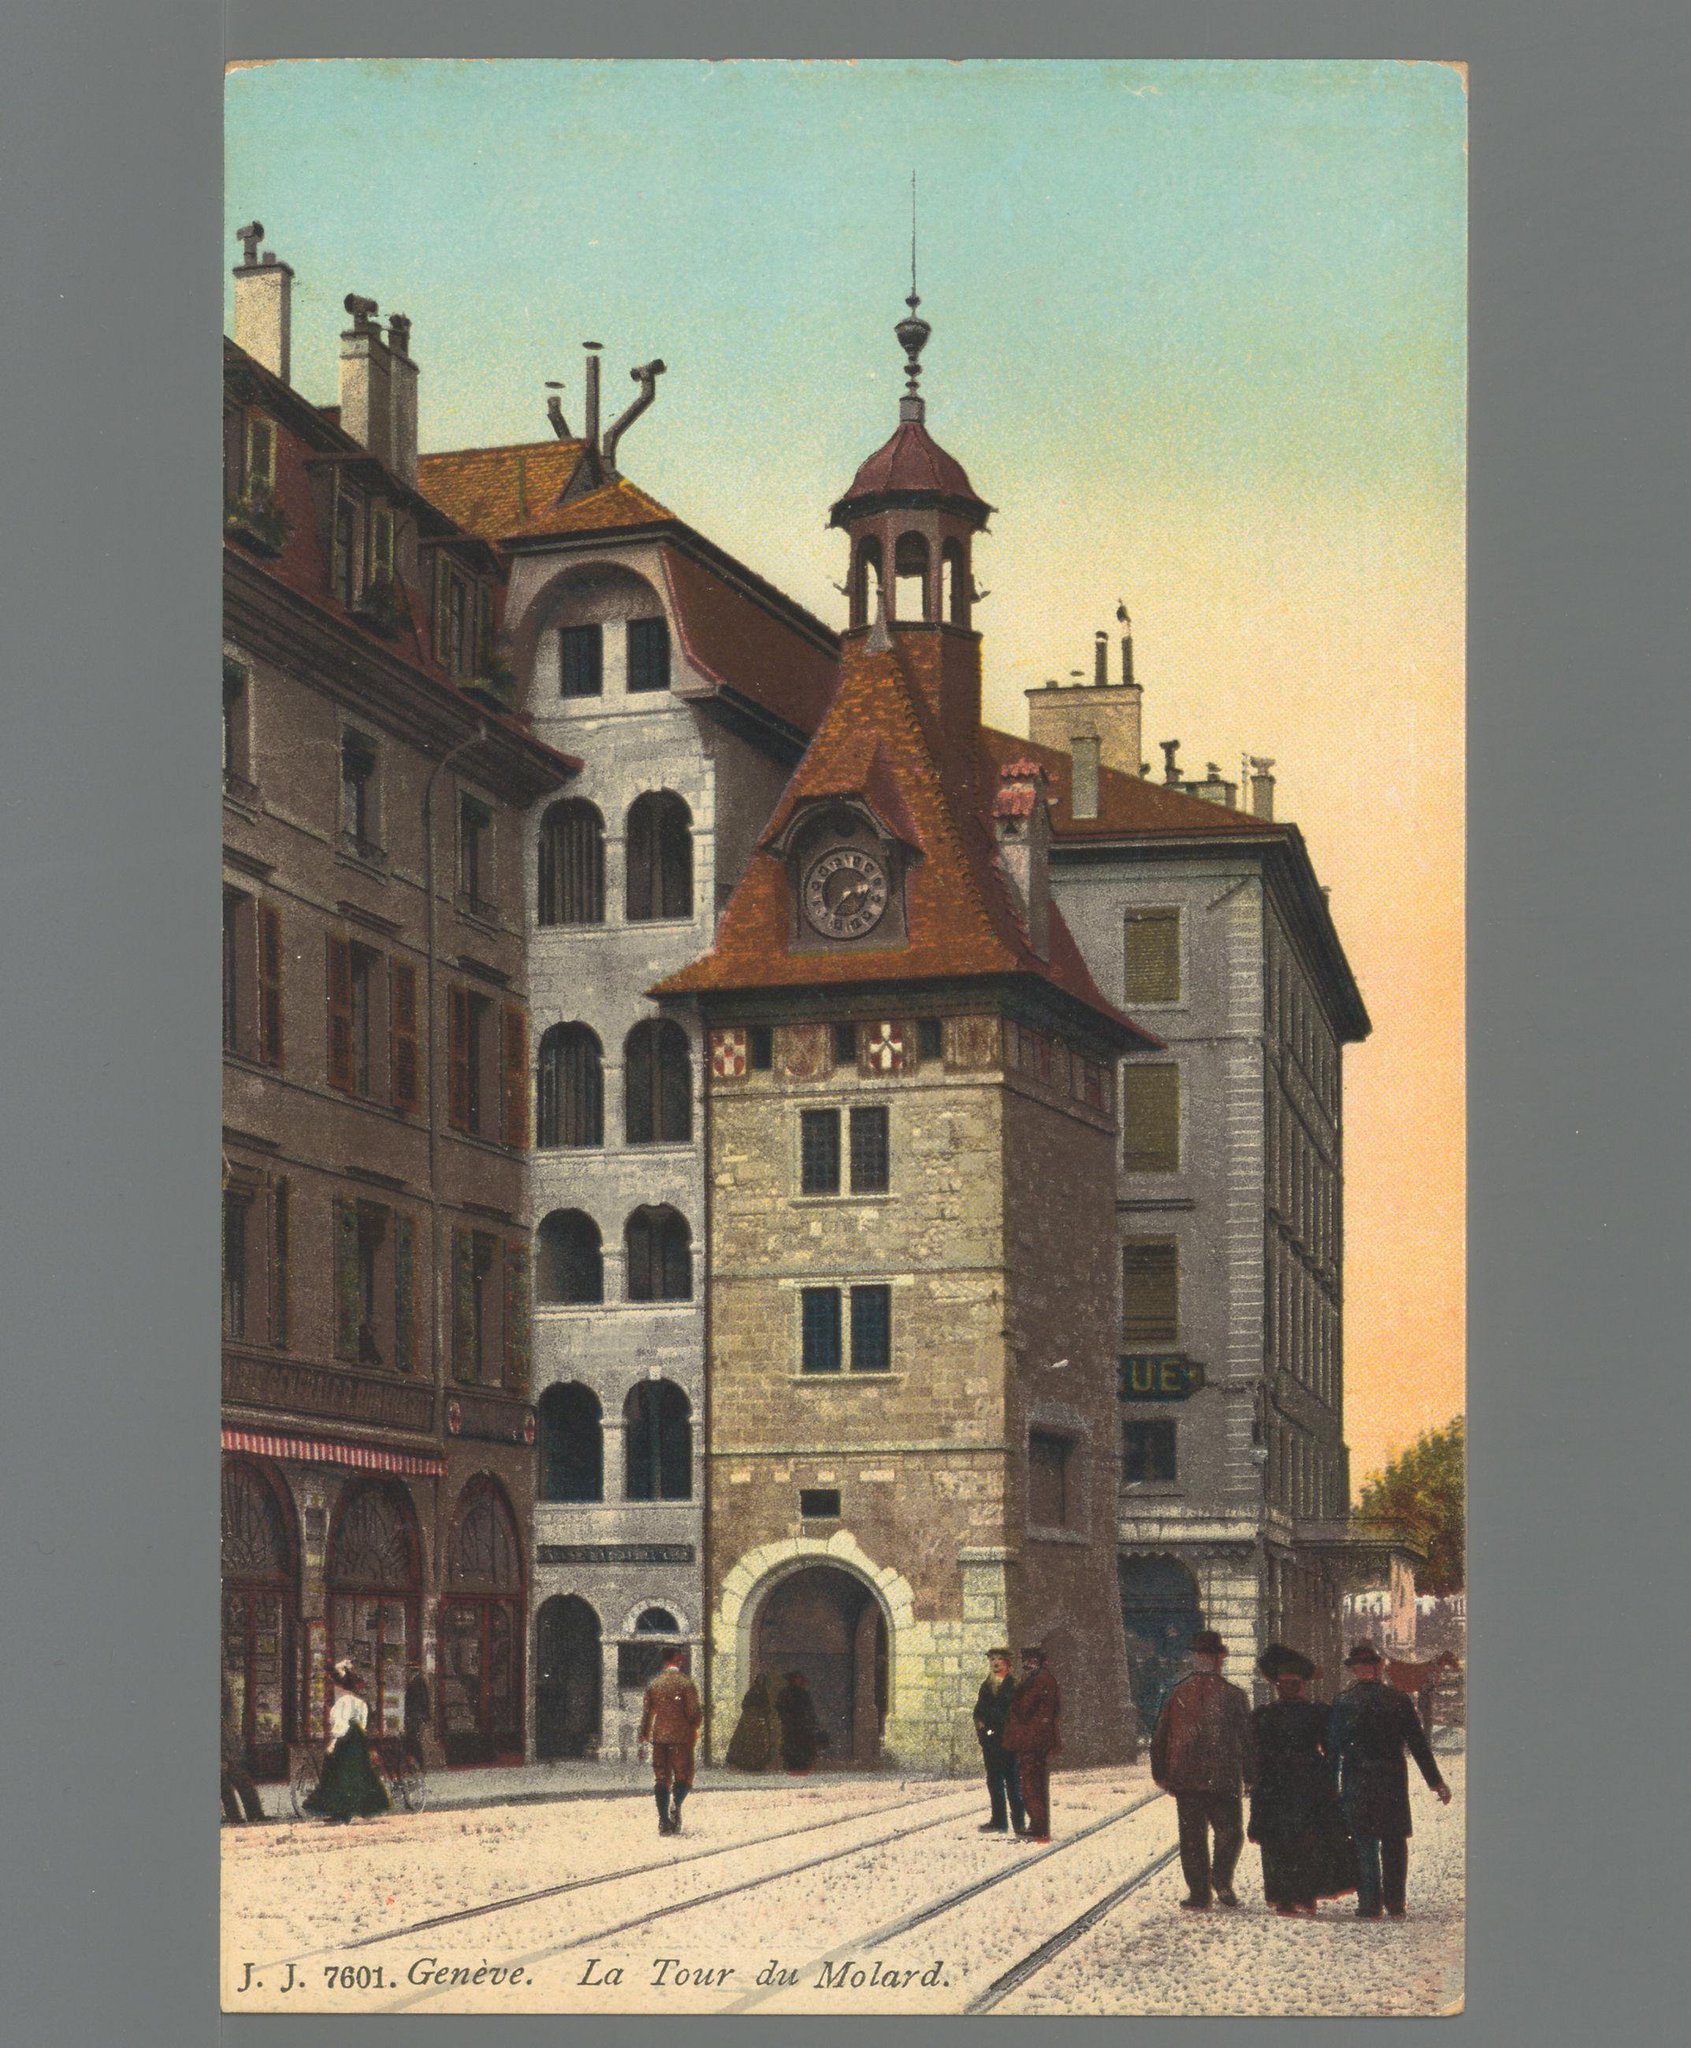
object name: photomechanical print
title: Genève. La Tour du Molard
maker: Anonymous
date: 1905-1918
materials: cardboard, photographic process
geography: geneva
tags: tramway, tram, tower, clock tower ~ monumental adornment (+ city(-scape) with figures, staffage)